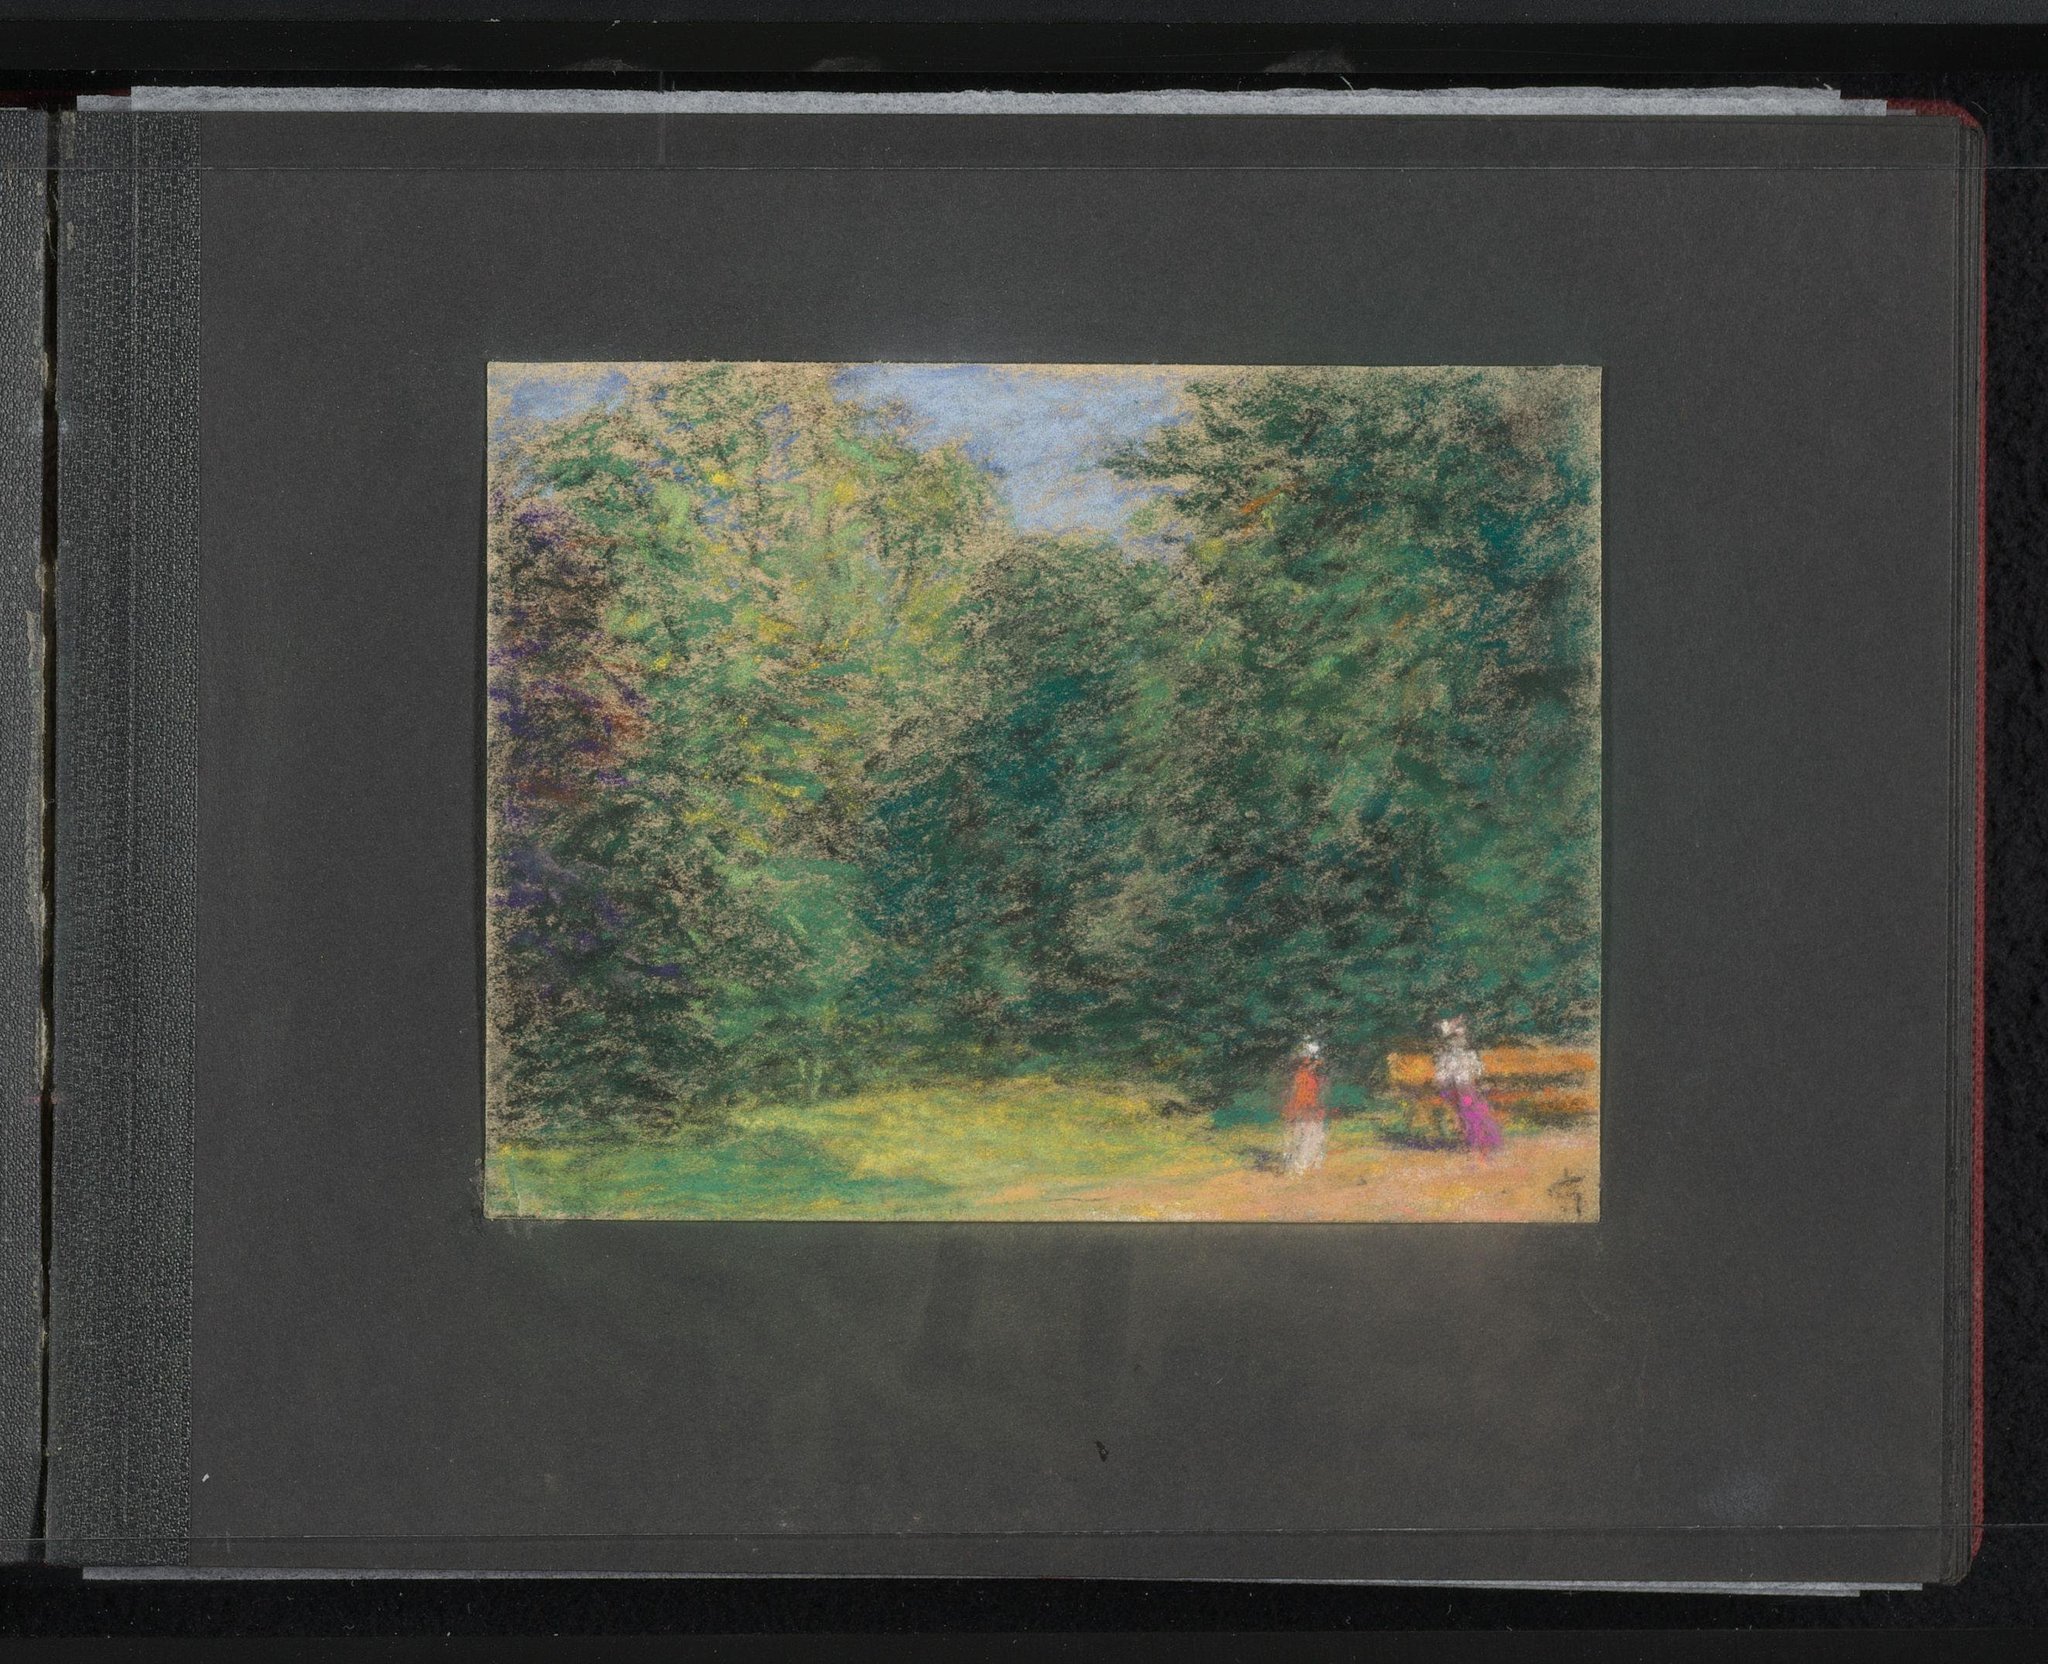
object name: album leaf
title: Park met twee mensen bij een bankje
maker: carel nicolaas storm van s-gravesande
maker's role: draughtsman, print maker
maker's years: 1841-1924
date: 1915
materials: chalk, paper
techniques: pasting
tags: garden pond, public gardens, park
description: Waarschijnlijk in het Kurpark te Wiesbaden. Tekening maakt deel uit van een album.